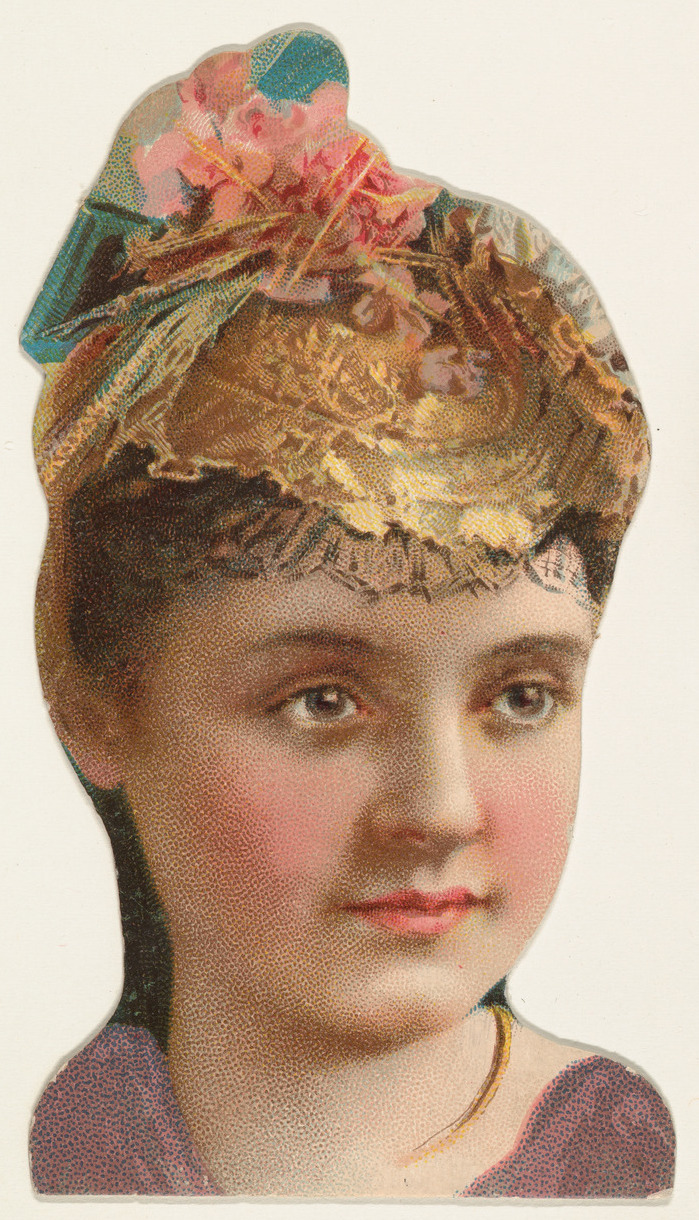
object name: print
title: Actress wearing hat with pink flowers and blue bow, from Stars of the Stage, Fourth Series (N132) issued by Duke Sons & Co. to promote Honest Long Cut Tobacco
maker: w. duke, sons & co.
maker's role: publisher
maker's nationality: american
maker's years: 1870-1920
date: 1892-1893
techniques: color lithograph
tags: portraits,women,actresses